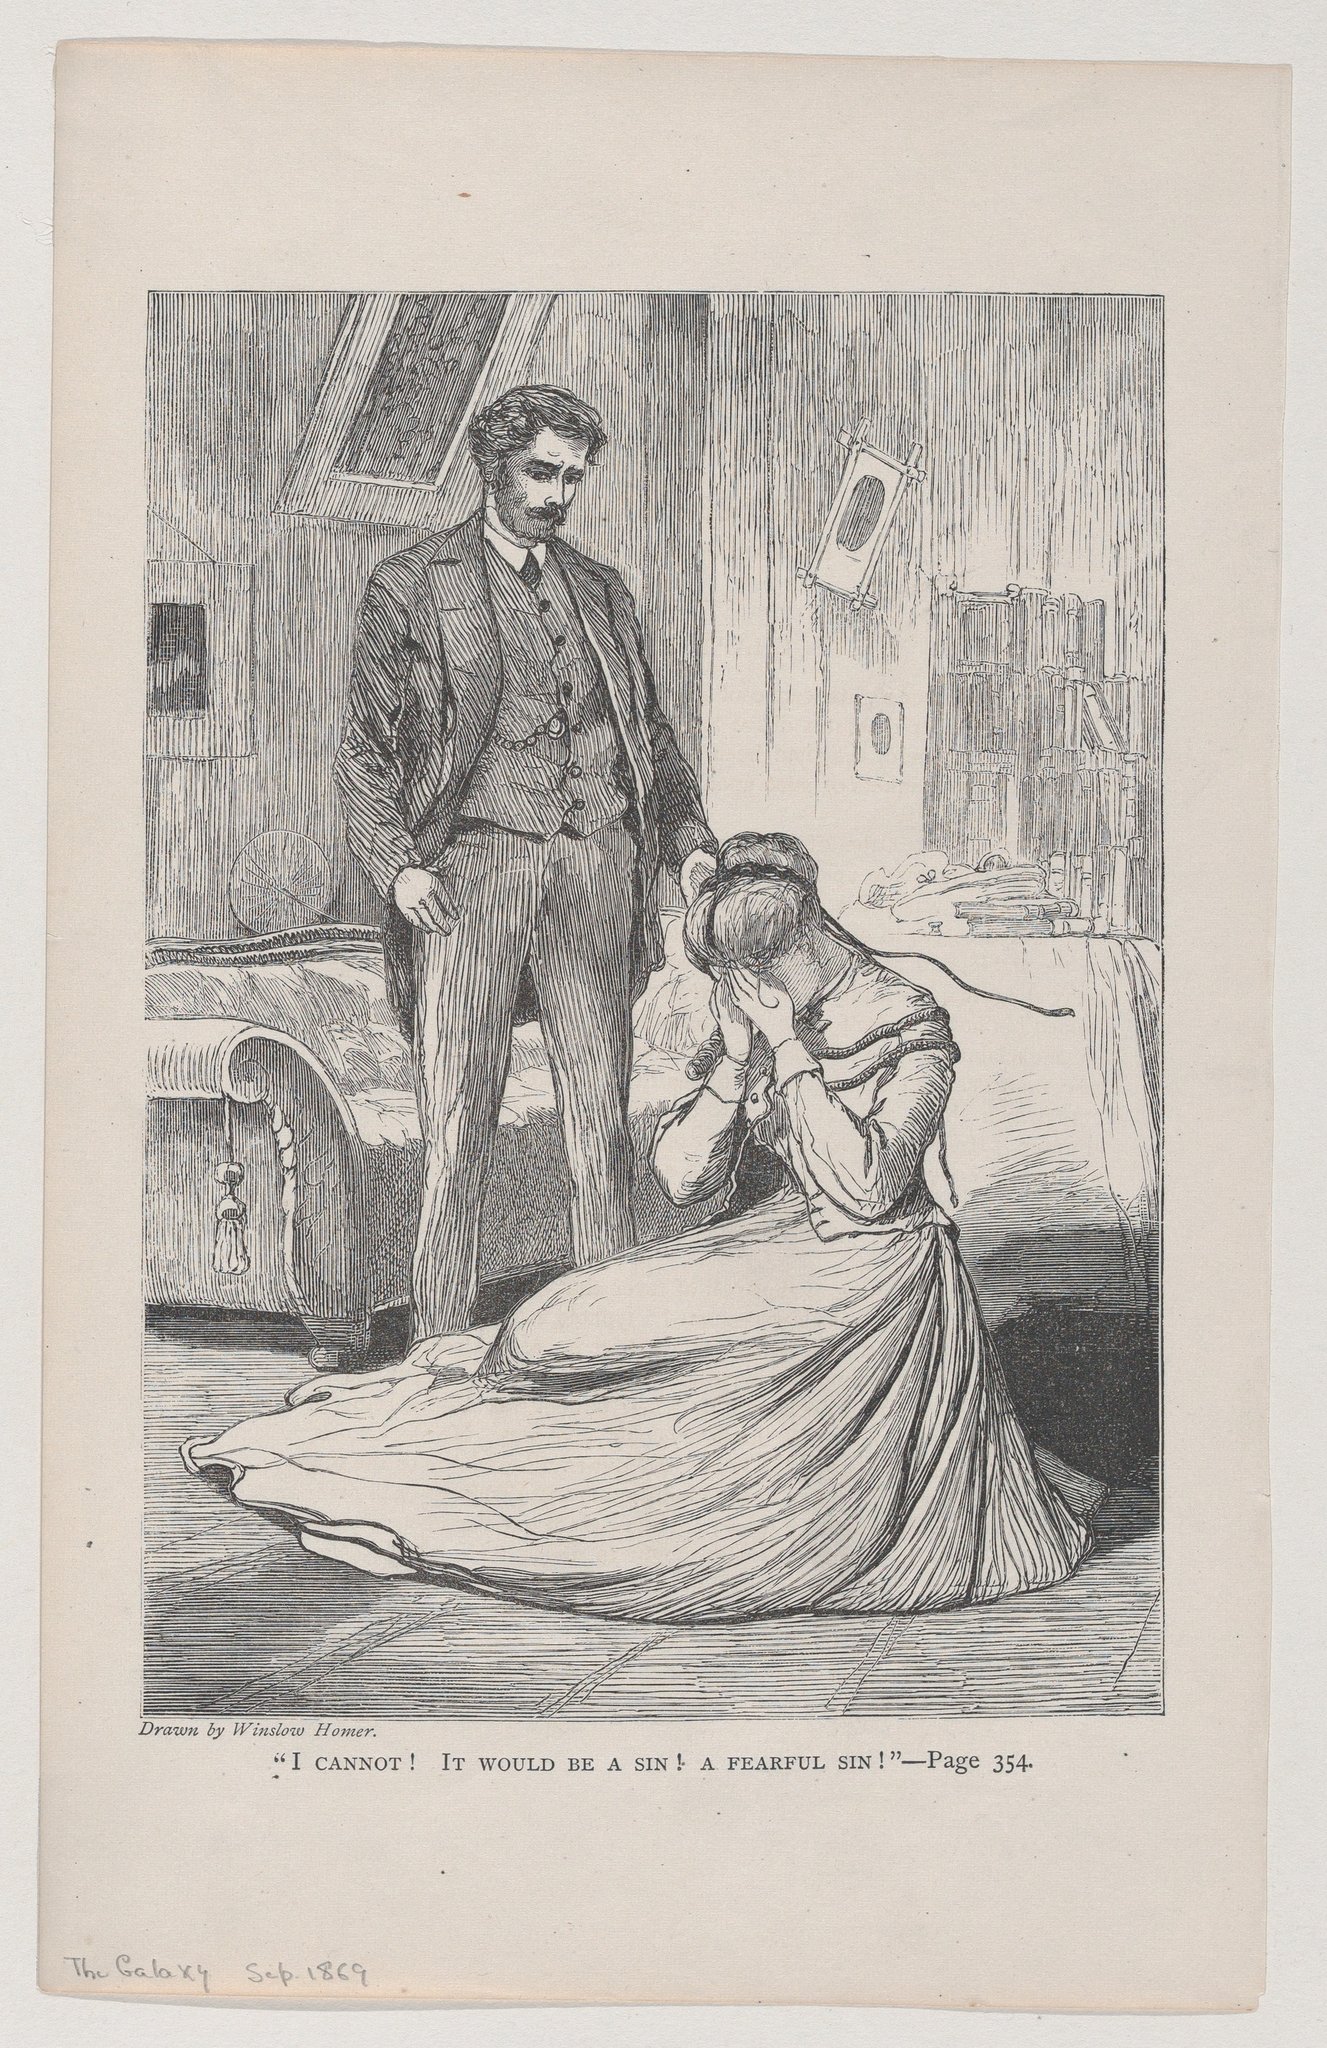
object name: print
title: "I Cannot! It Would Be a Sin! A Fearful Sin!" (The Galaxy, An Illustrated Magazine of Entertaining Reading, Vol. VI)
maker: winslow homer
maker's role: artist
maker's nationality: american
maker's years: 1836-1910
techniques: engraving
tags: men,women